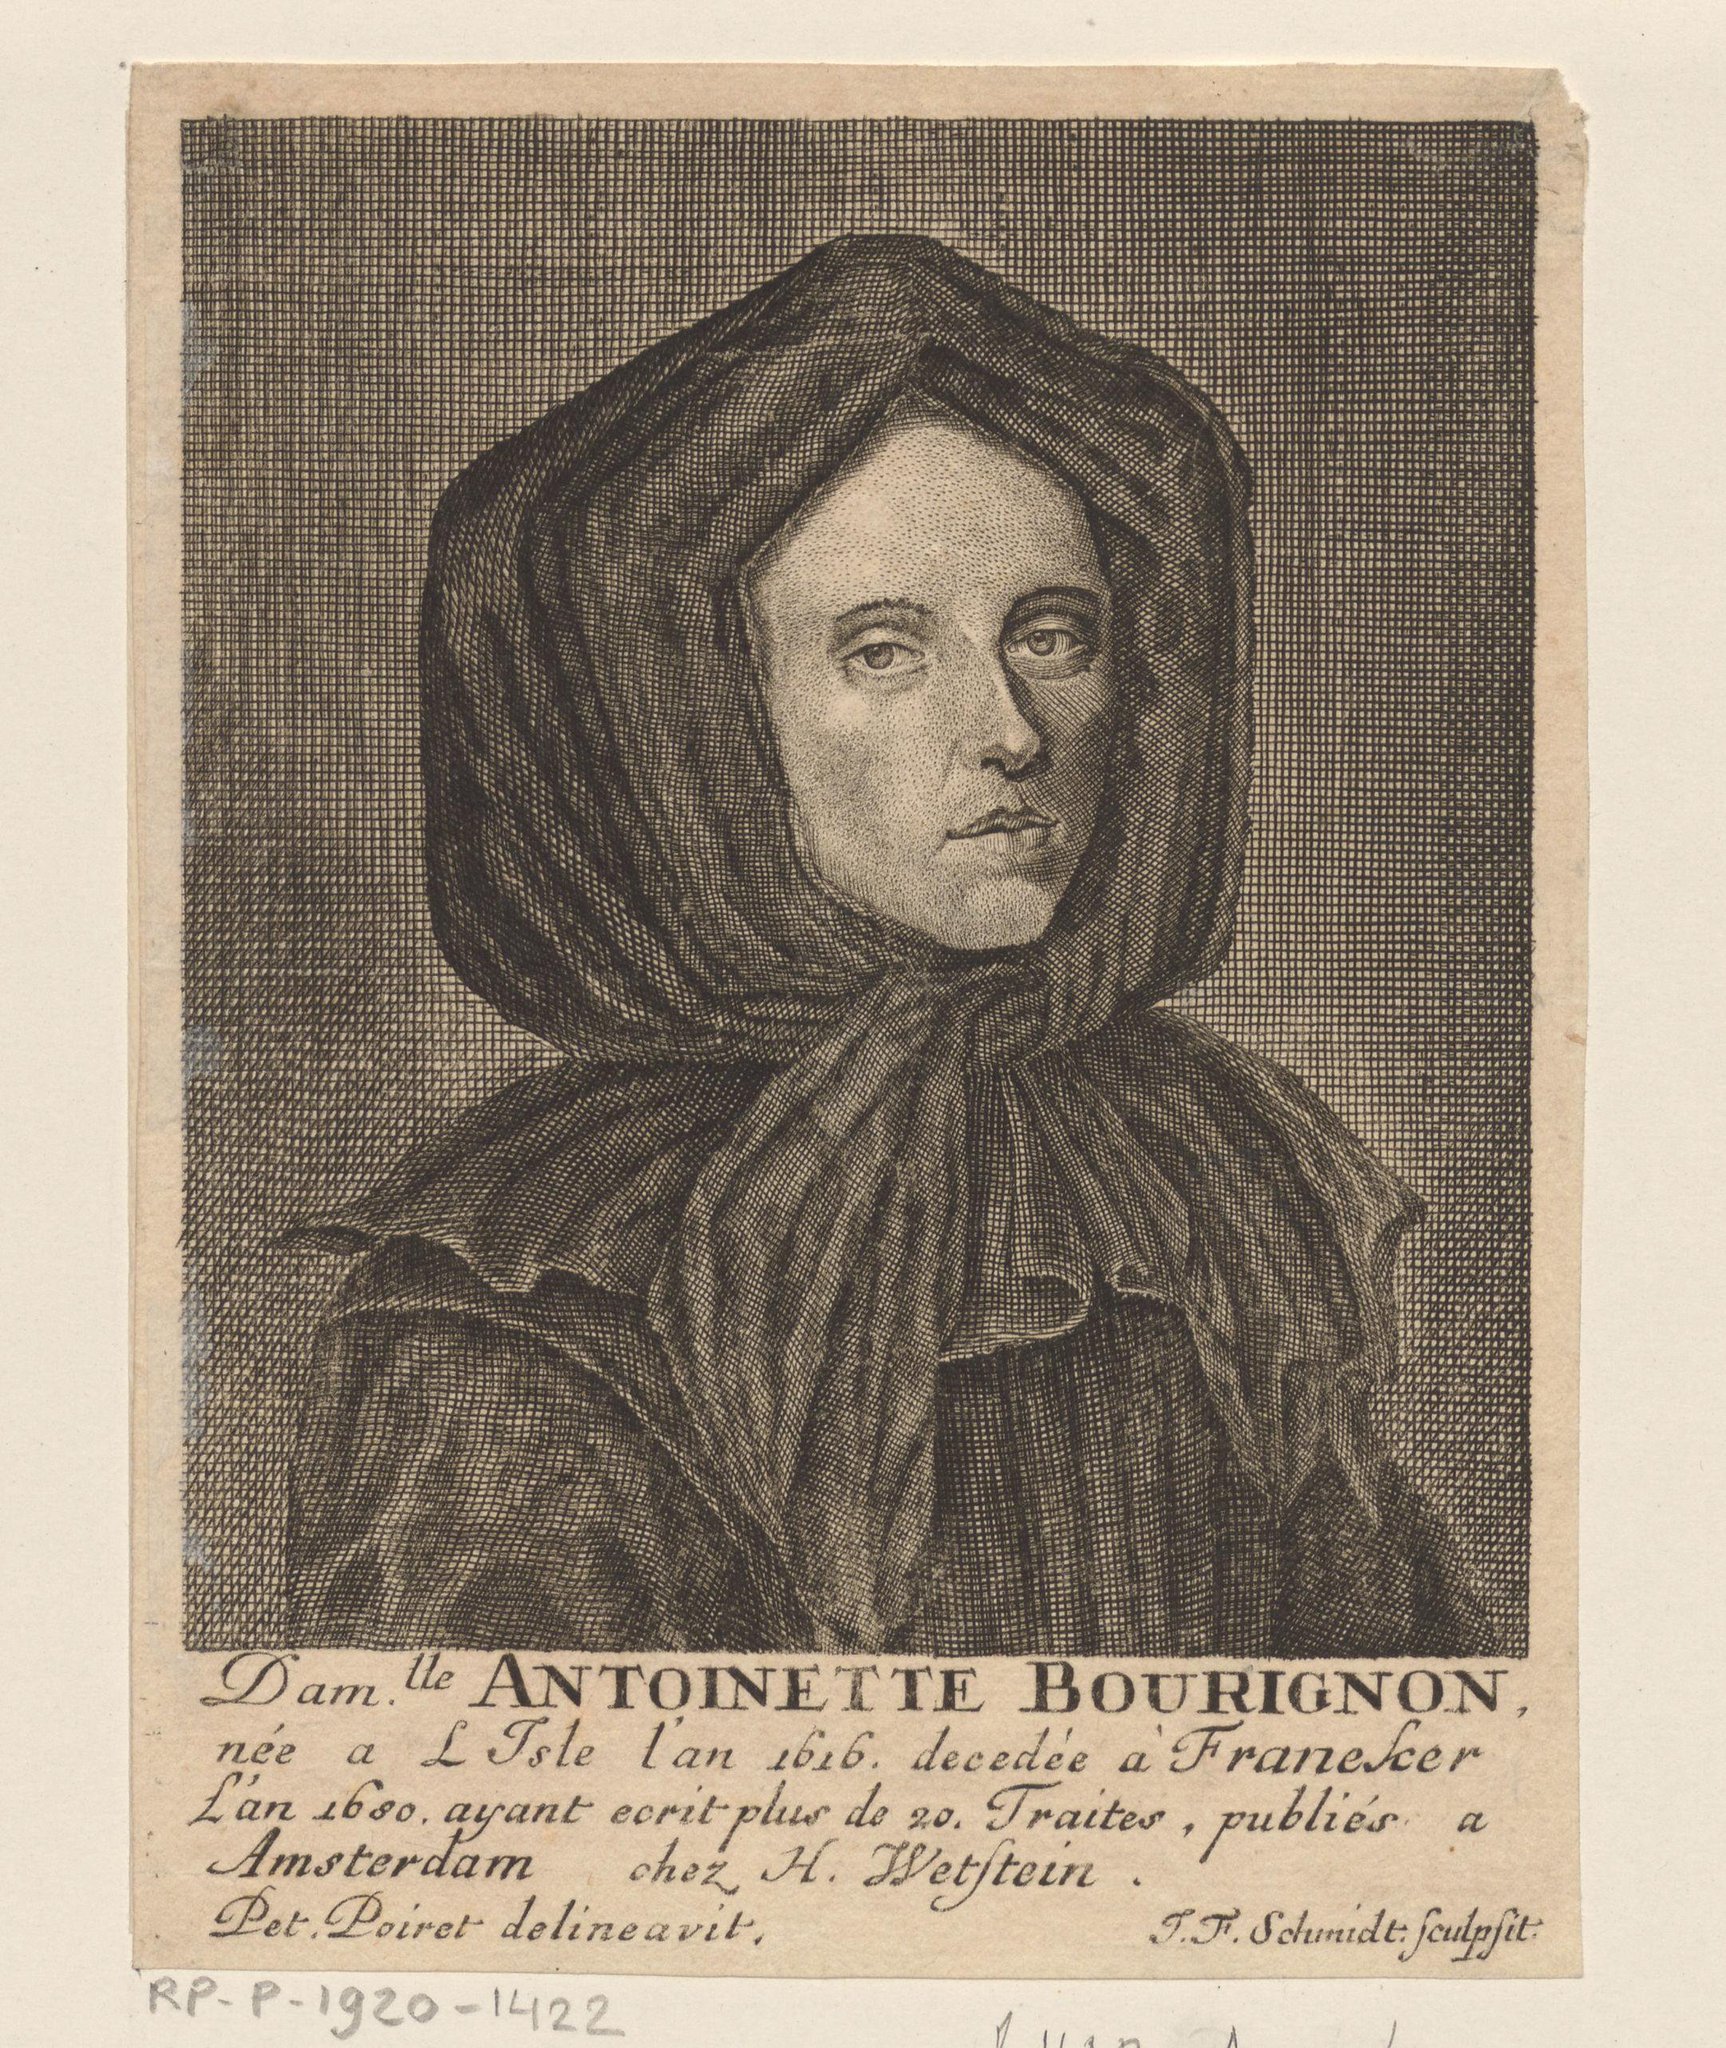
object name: print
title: Portret van Antoinette Bourignon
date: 1700-1799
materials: paper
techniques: engraving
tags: lille, historical persons - bb - woman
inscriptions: collector's mark: Lugt 2228